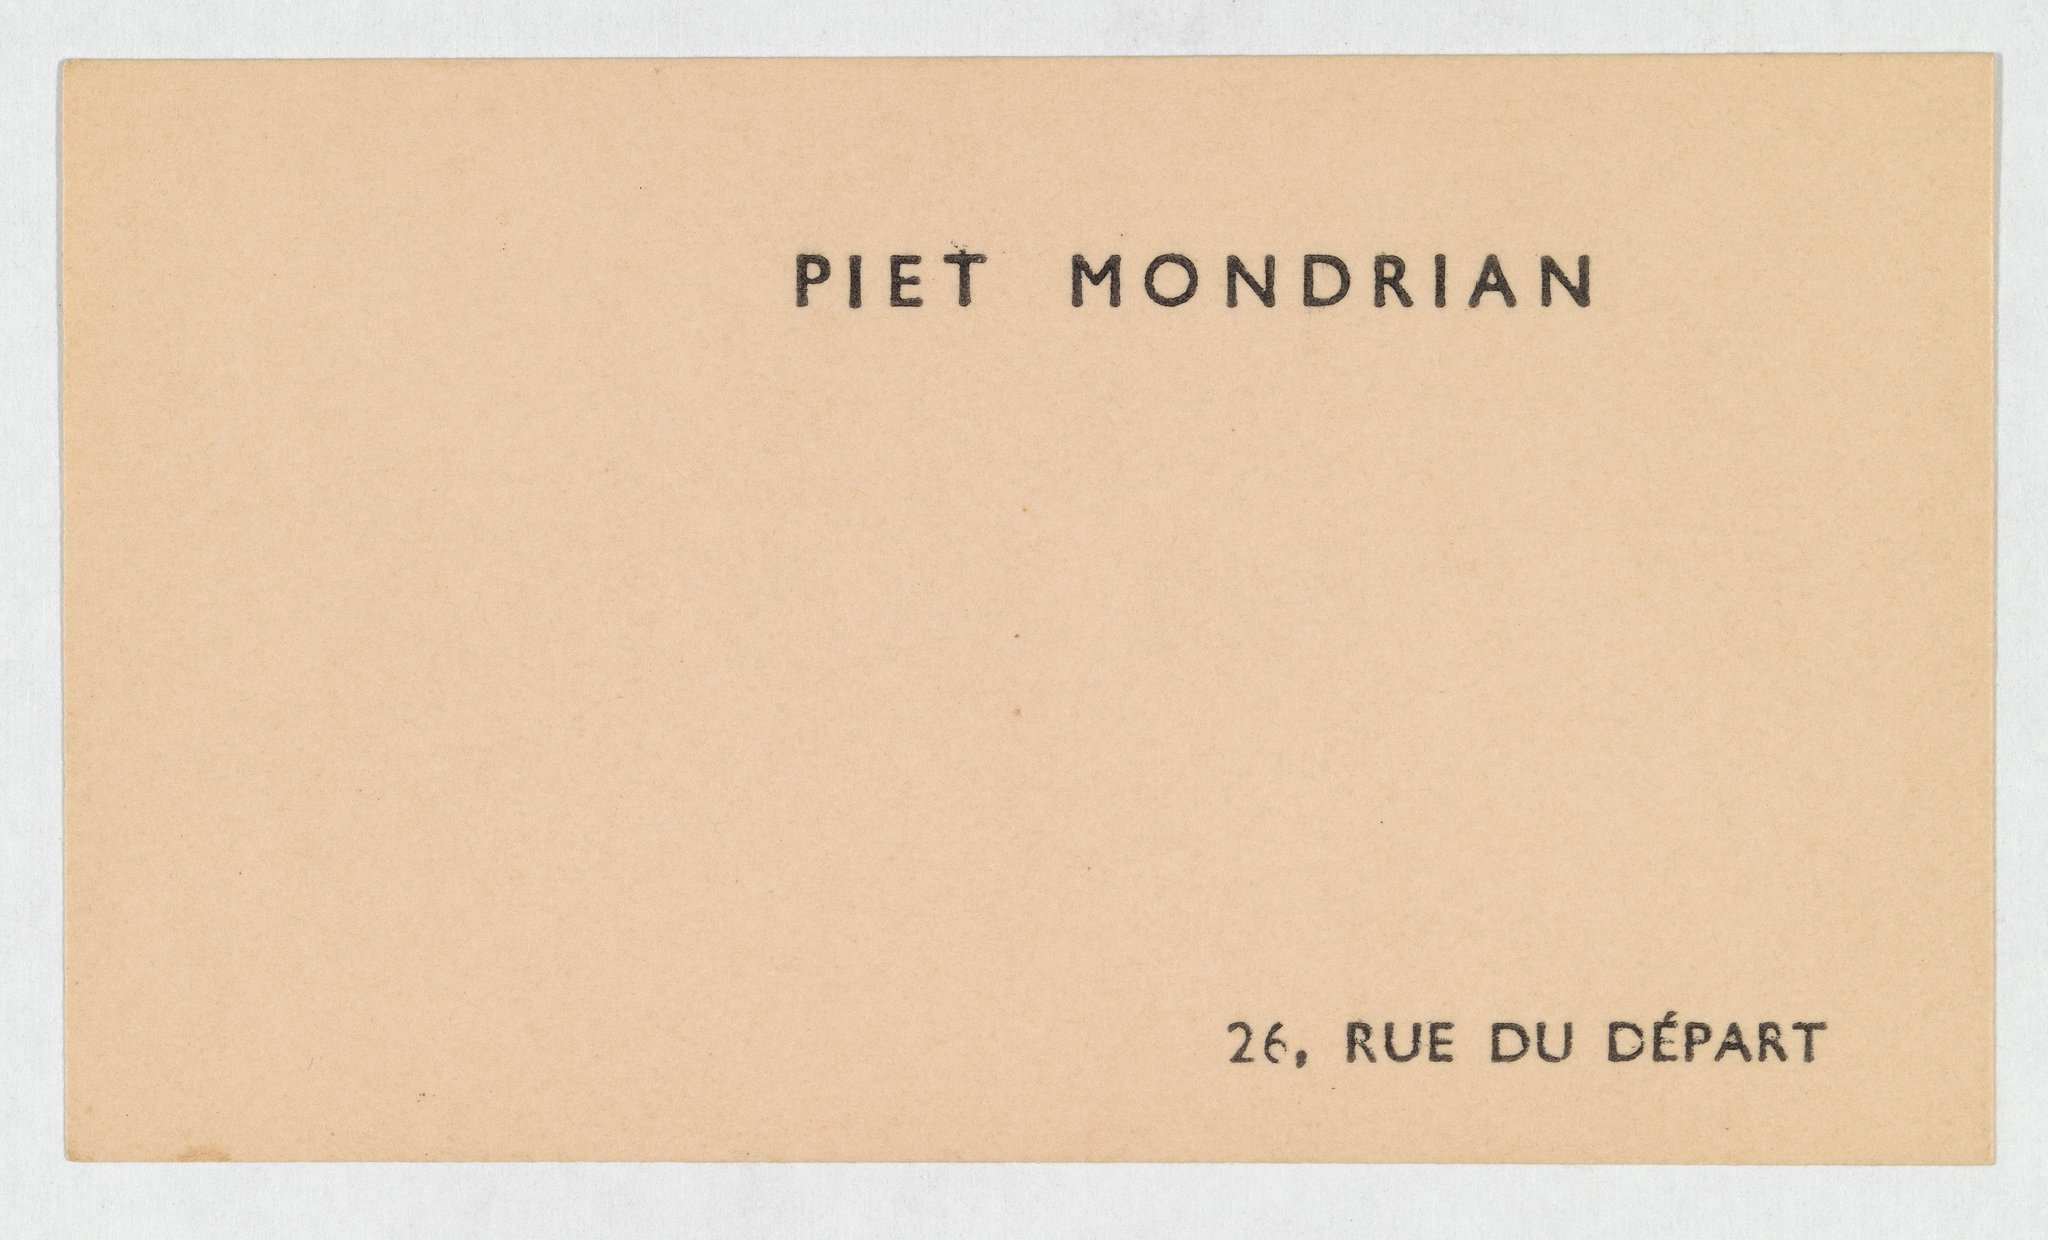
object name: print, calling card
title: Piet Mondrian, calling card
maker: Anonymous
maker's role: artist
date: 1919-1938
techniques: letterpress